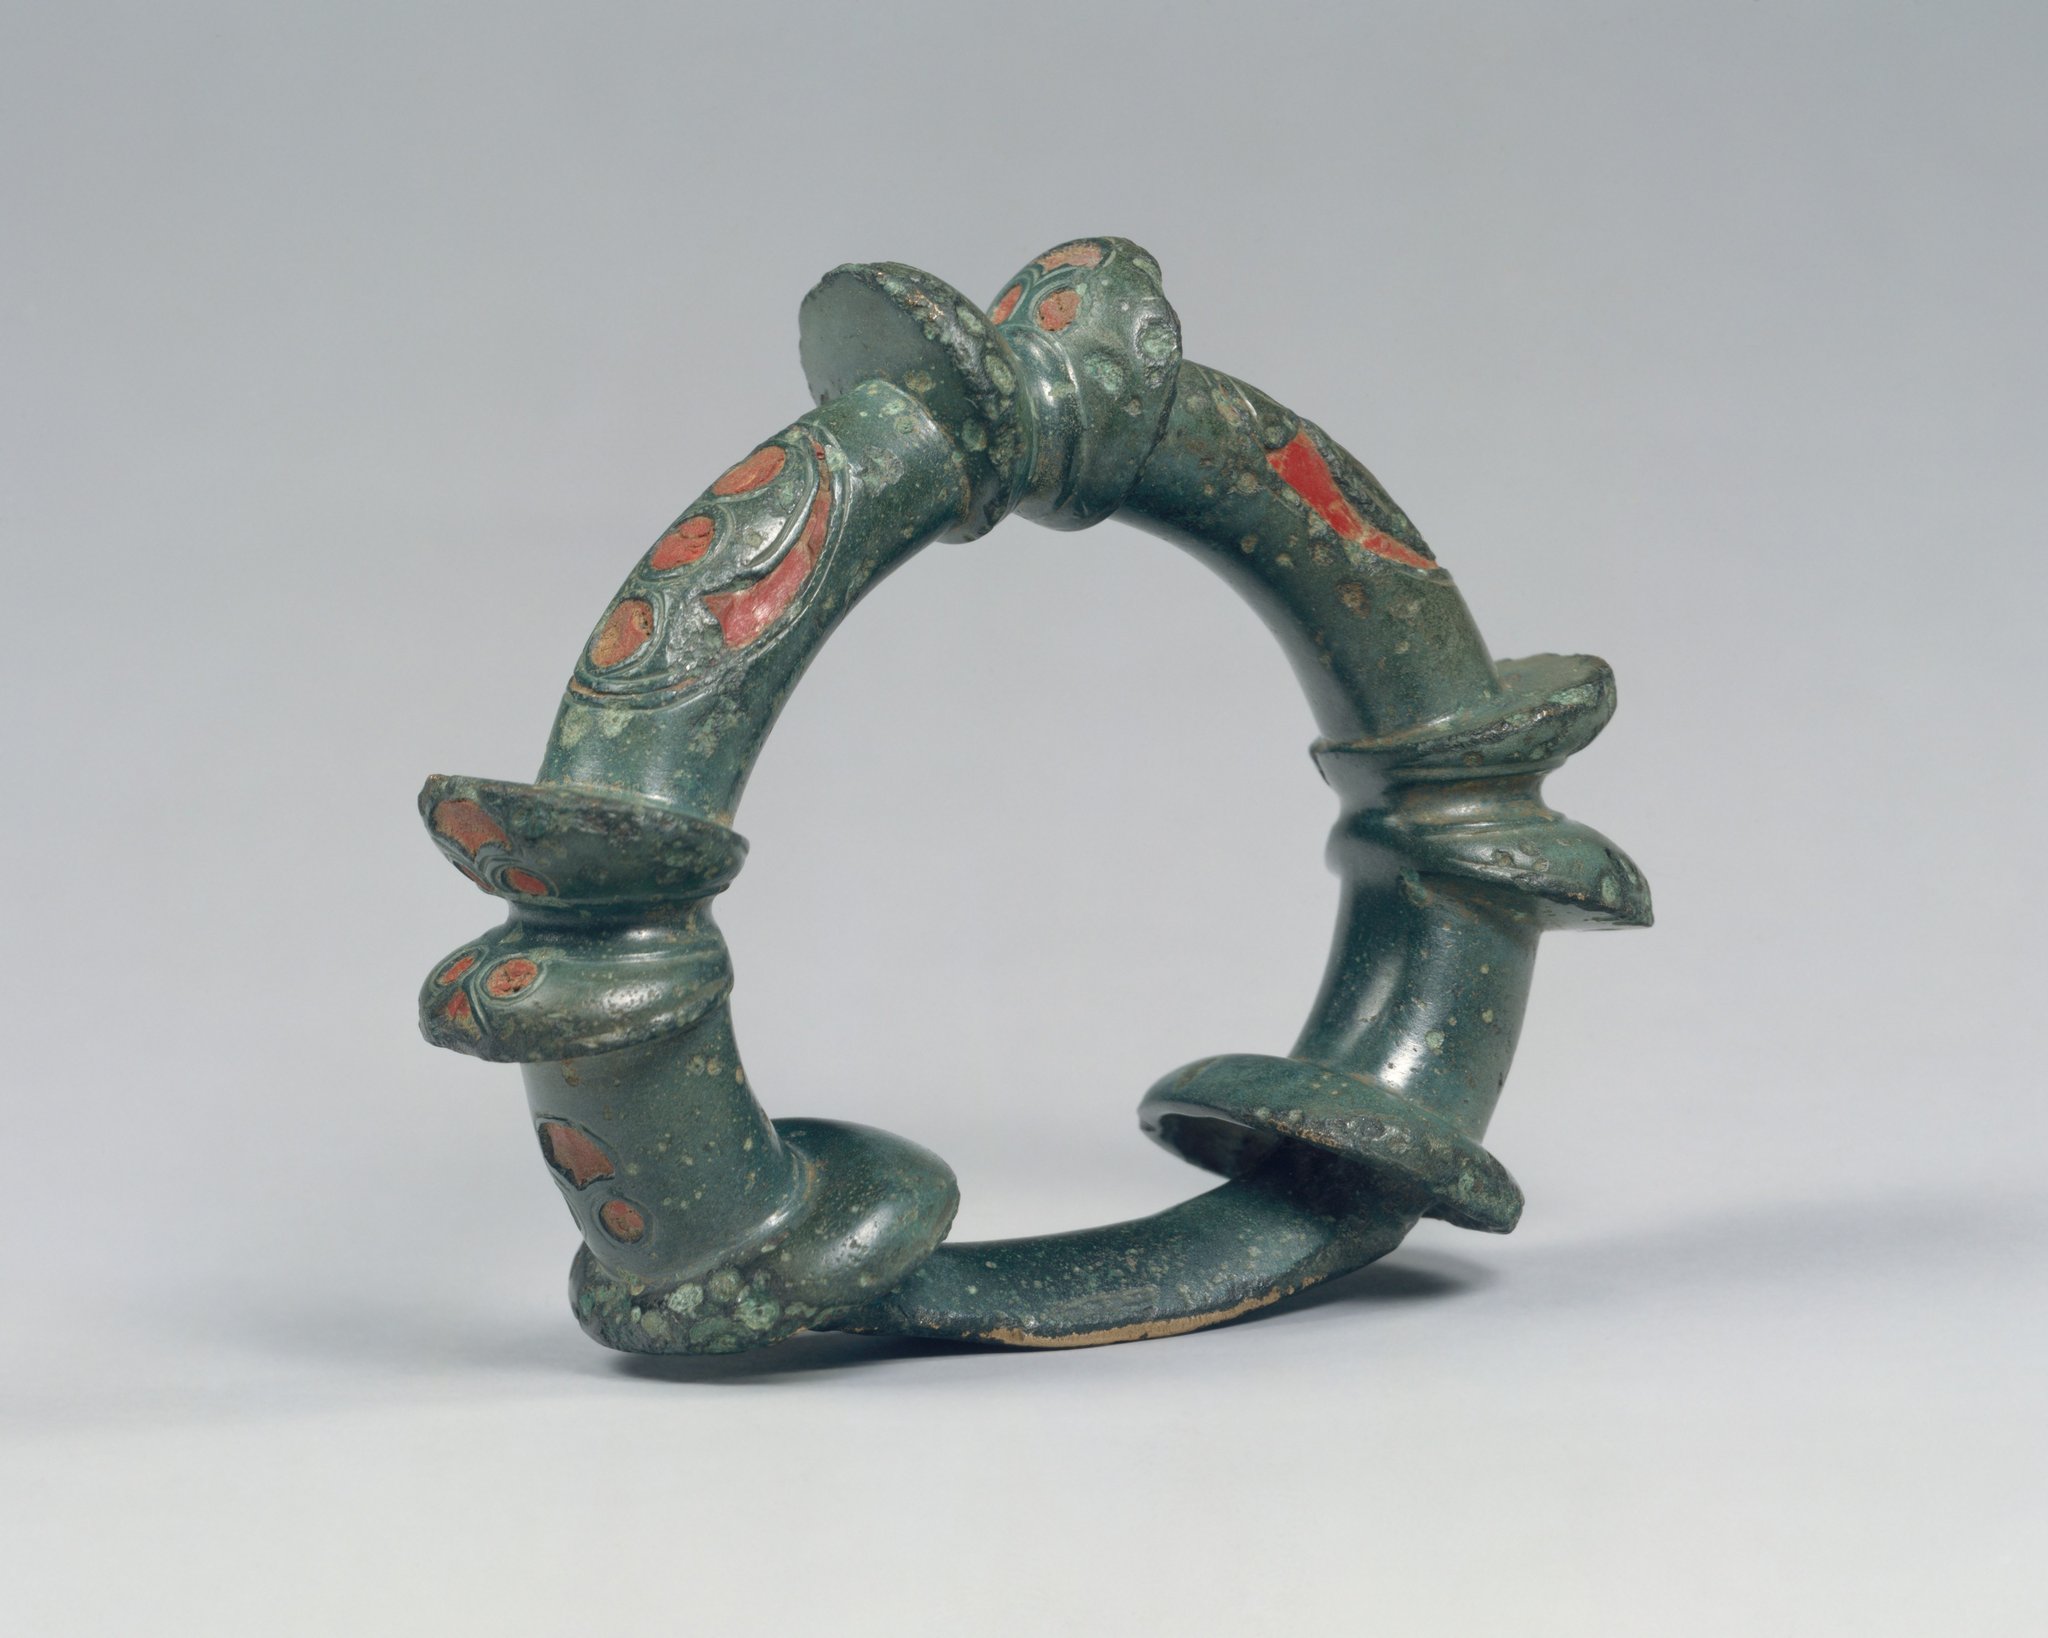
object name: terret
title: Terret (Rein Guide)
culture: celtic or roman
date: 1-100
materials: copper alloy, enamel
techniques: enamel